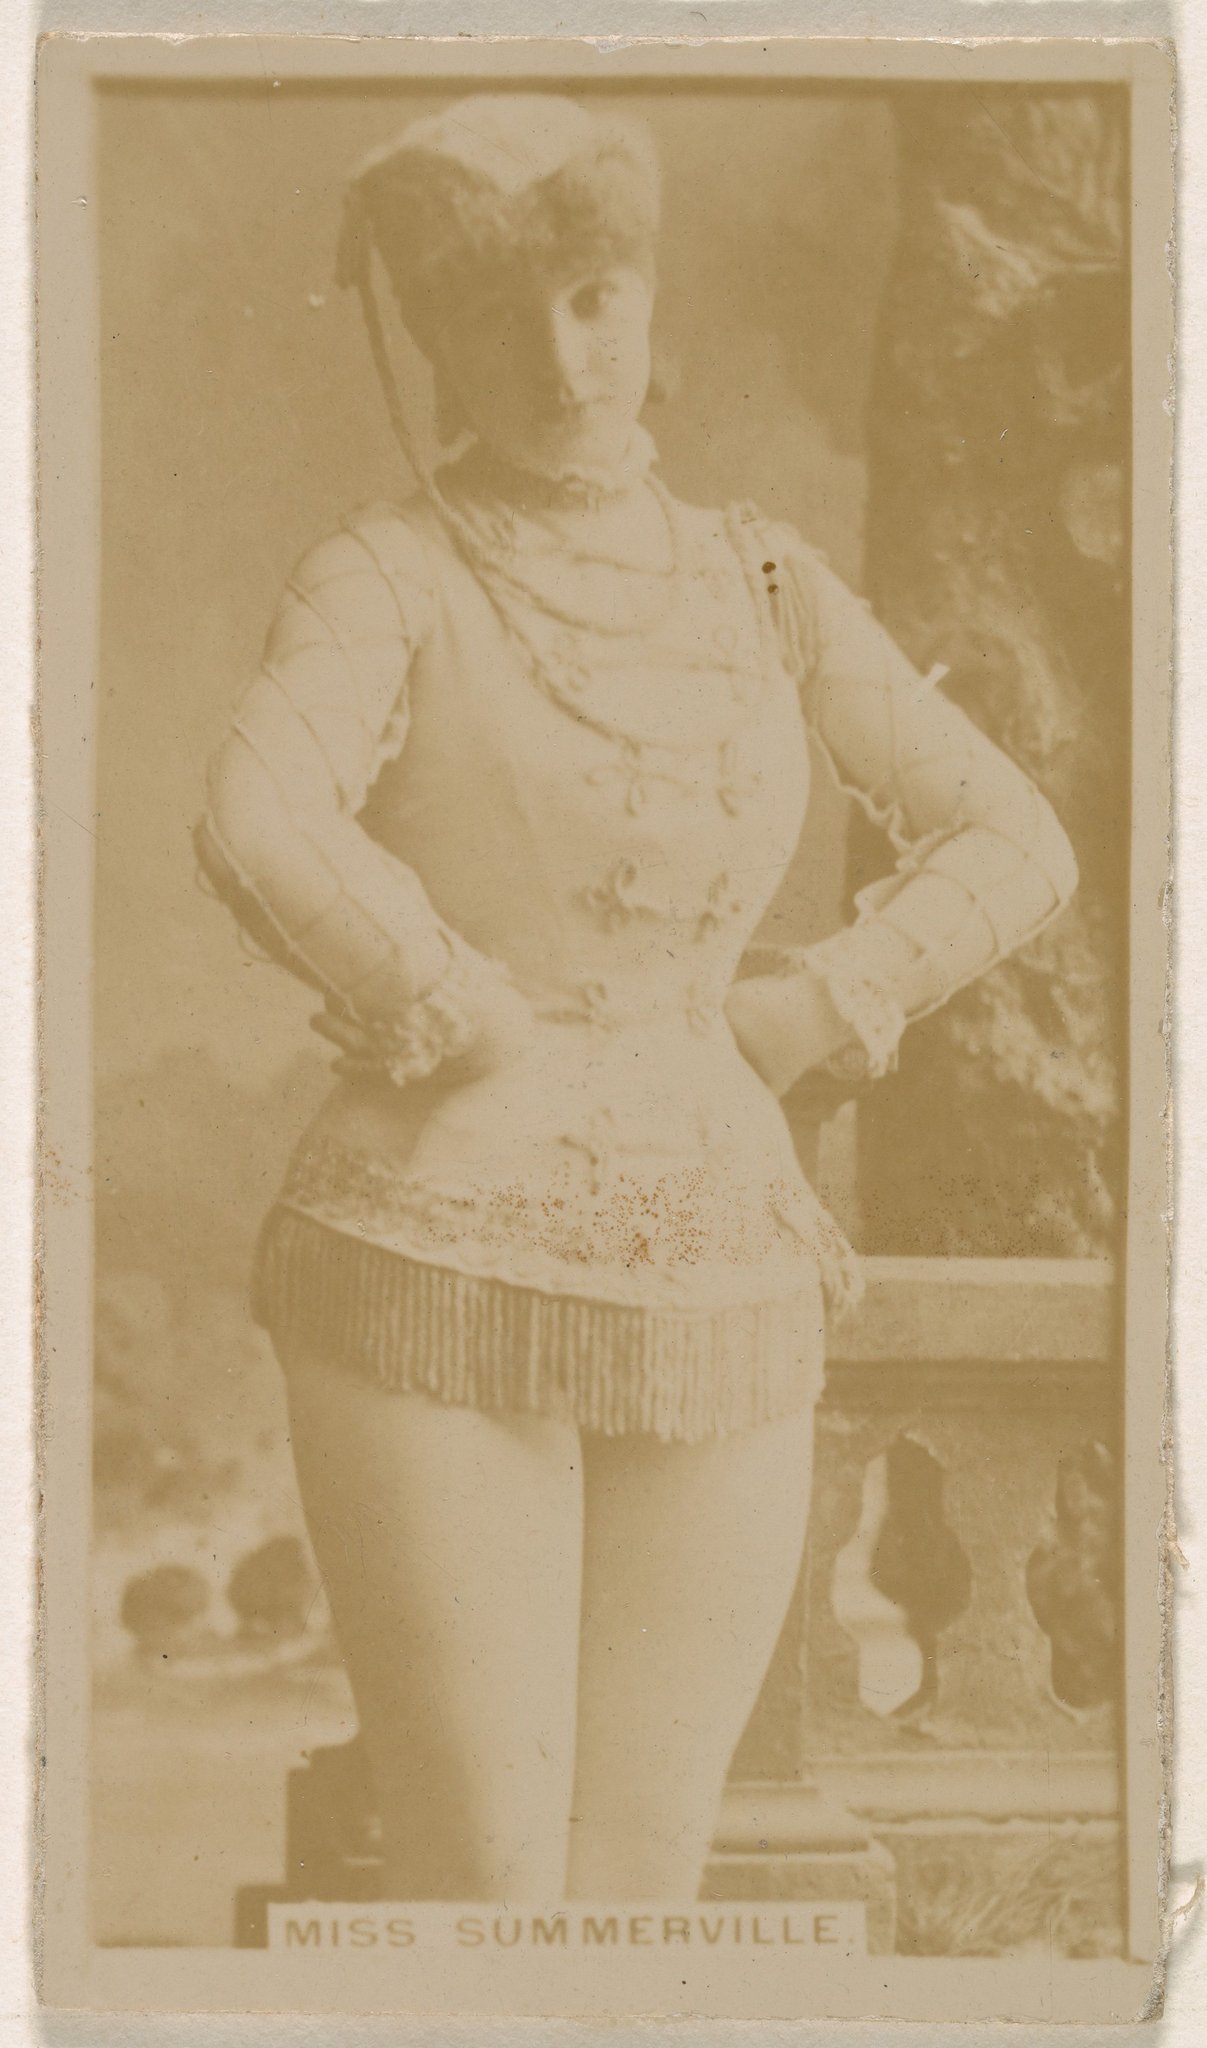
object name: photograph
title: Miss Annie Summerville, from the Actresses series (N245) issued by Kinney Brothers to promote Sweet Caporal Cigarettes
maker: kinney brothers tobacco company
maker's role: publisher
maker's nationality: american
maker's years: 1869-2011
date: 1890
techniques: albumen silver print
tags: portraits,women,actresses